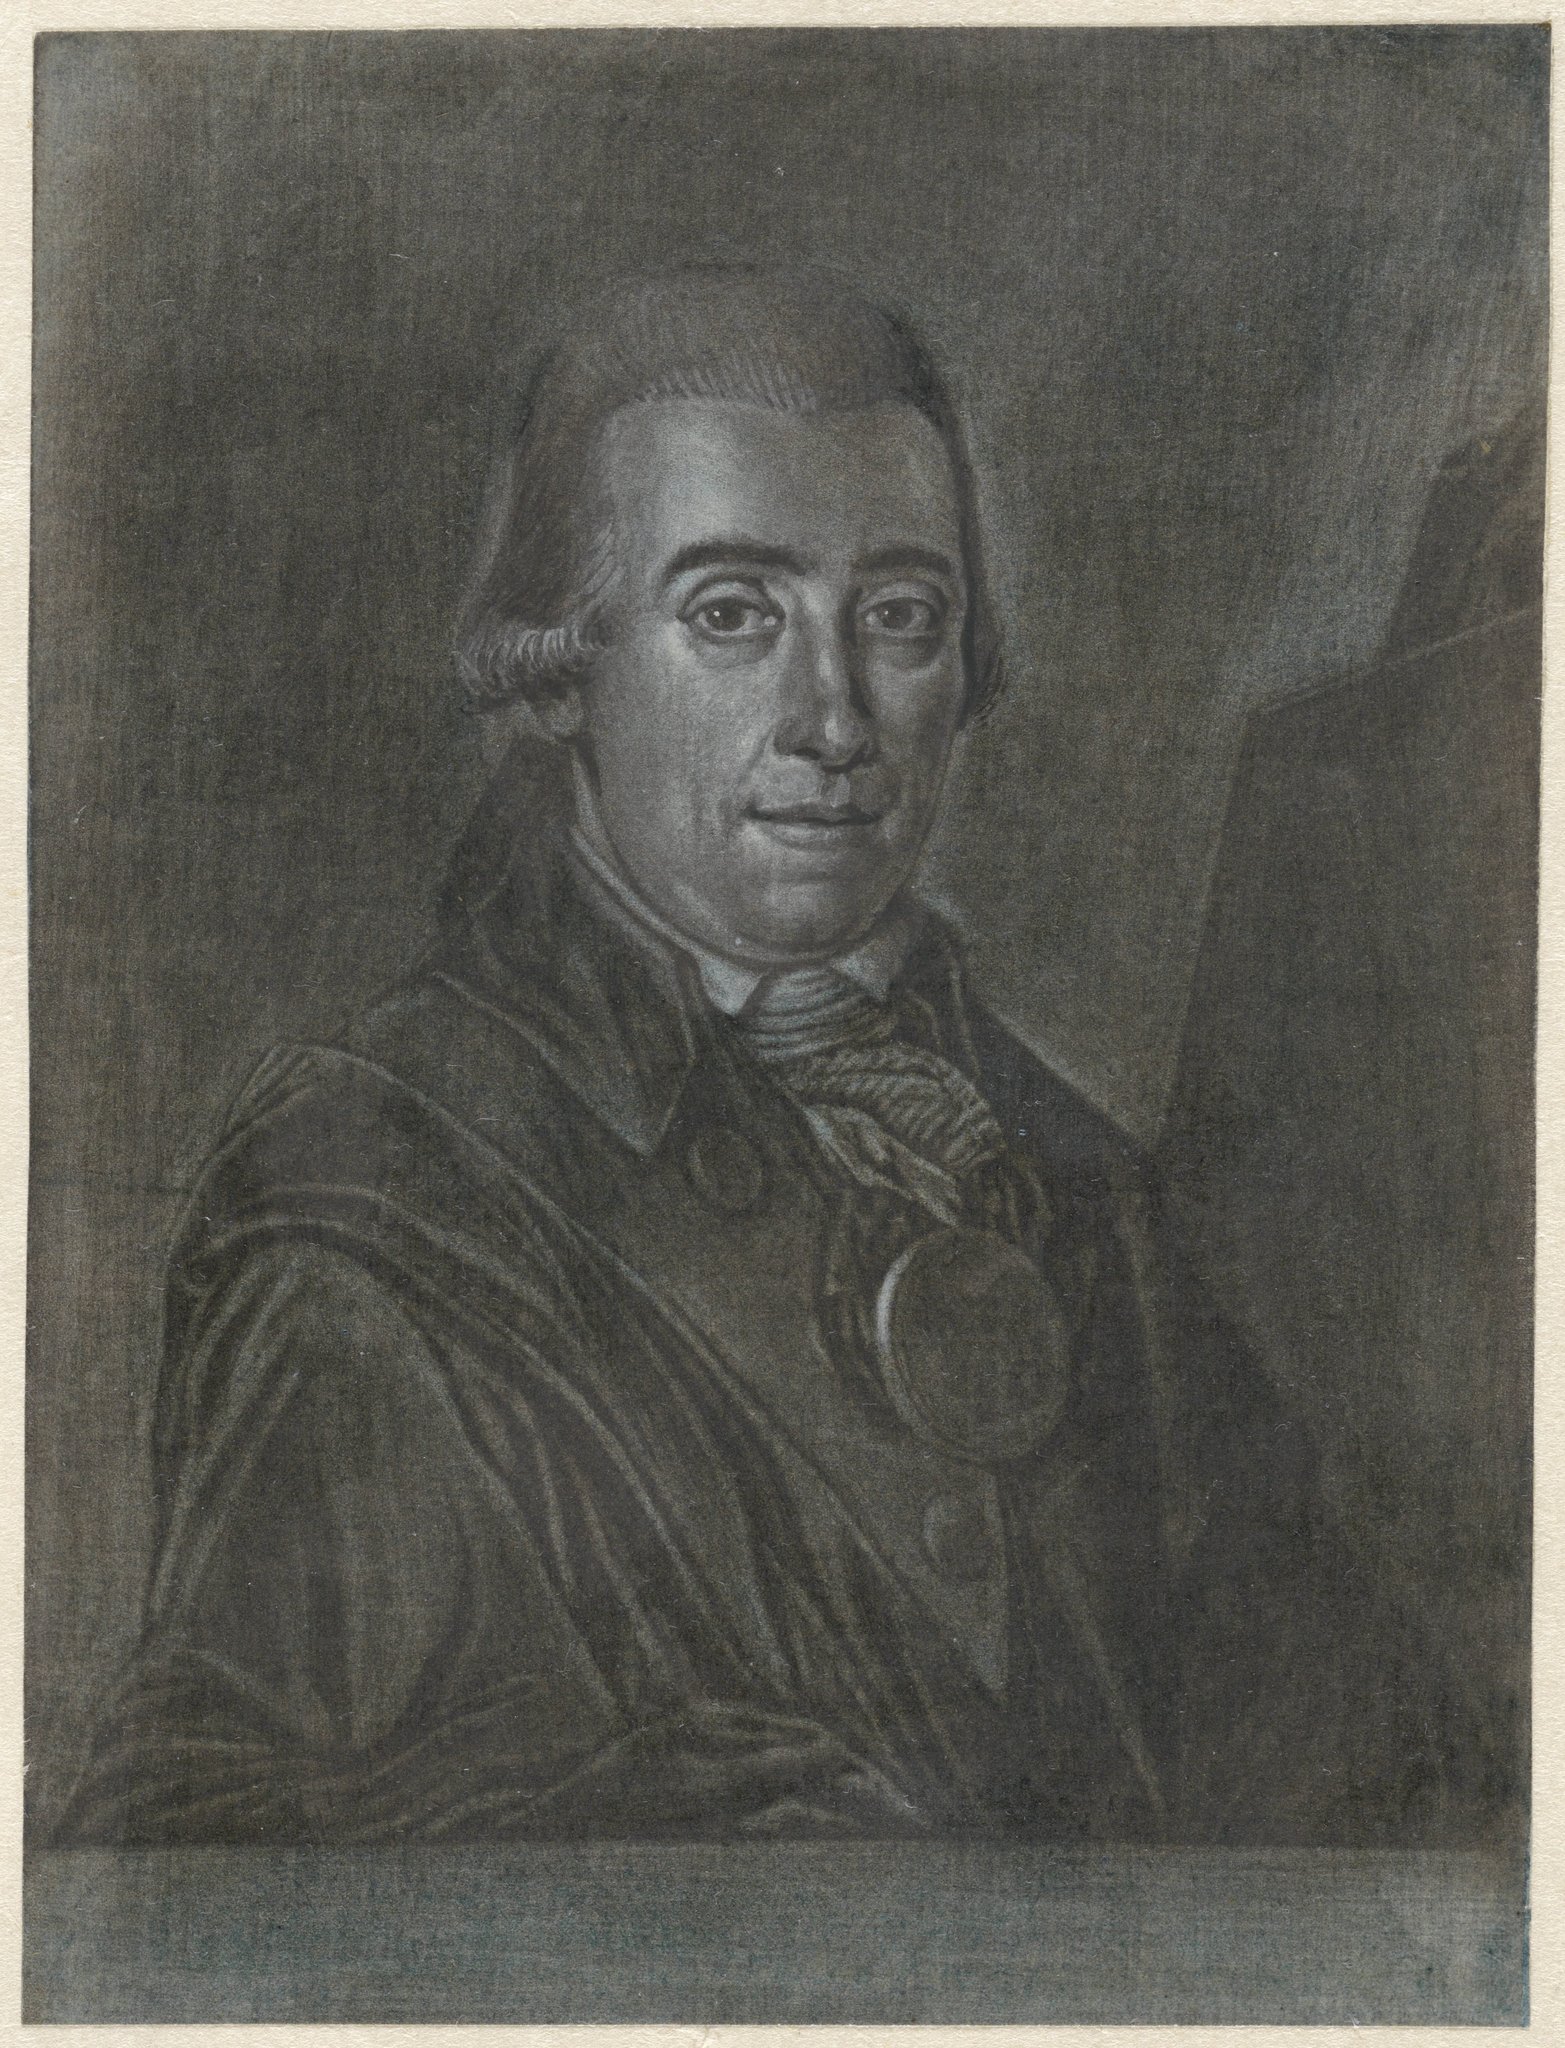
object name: print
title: Portret van een schilder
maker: Anonymous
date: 1725-1774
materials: paper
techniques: mezzotint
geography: netherlands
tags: portrait, self-portrait of painter, easel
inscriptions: collector's mark: Lugt 2760, collector's mark: Lugt 2228